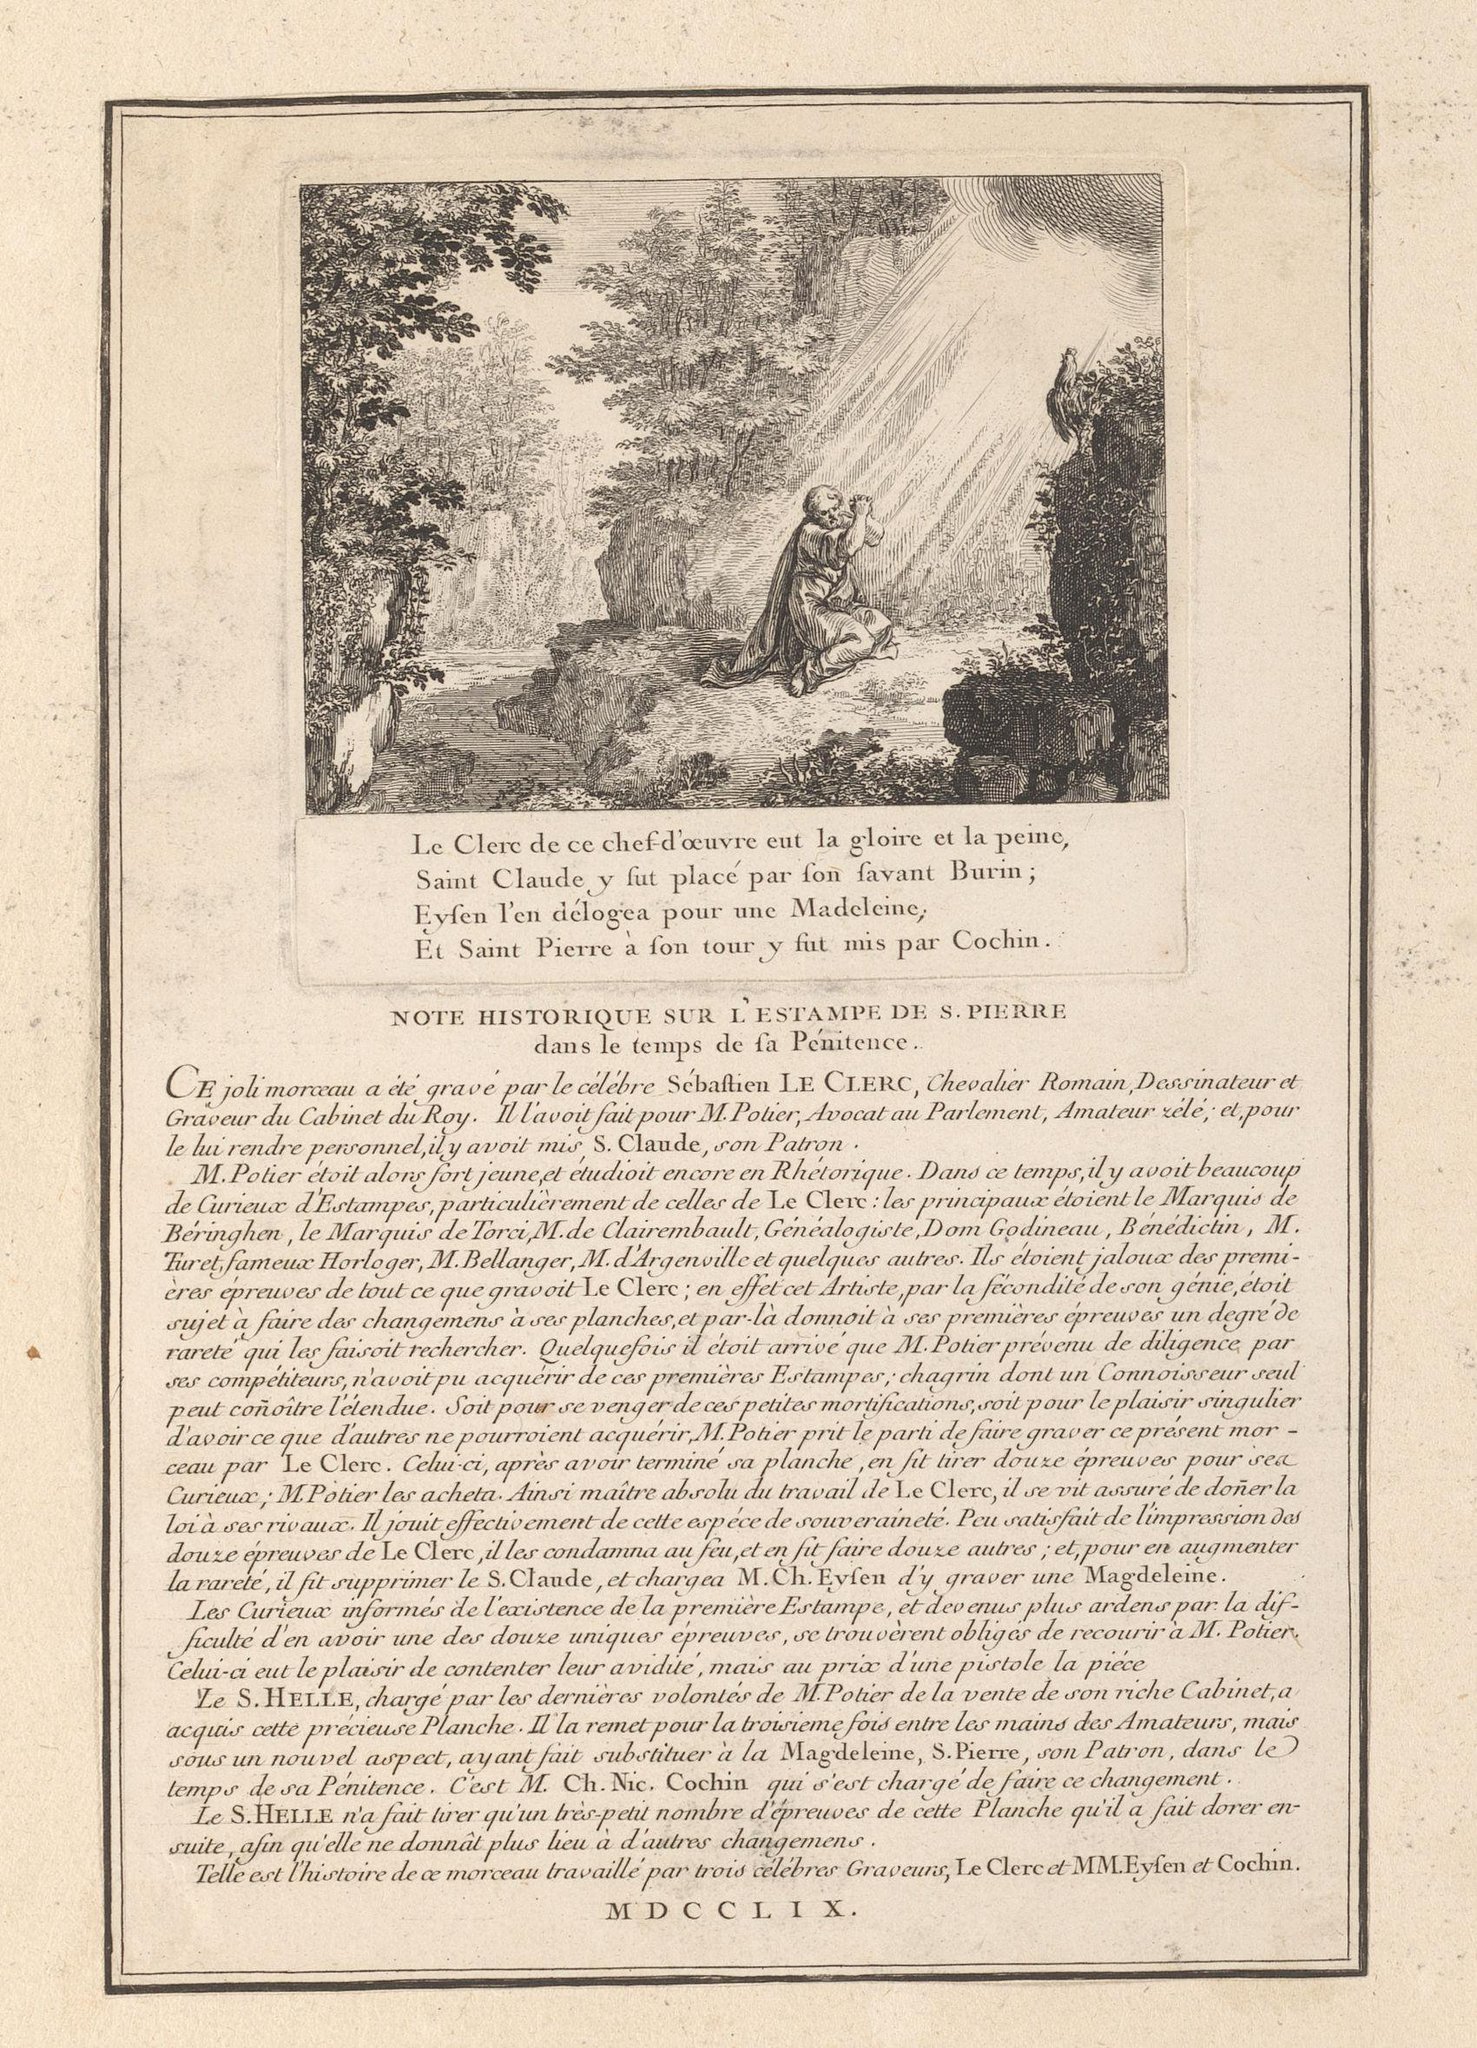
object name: print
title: Knielende Petrus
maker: sébastien leclerc (i)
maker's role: print maker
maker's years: 1637-1714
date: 1647-1714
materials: paper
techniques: etching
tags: the apostle peter, first bishop of rome; possible attributes: book, cock, (upturned) cross, (triple) crozier, fish, key, scroll, ship, tiara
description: Met aanpassingen door Charles Nicolas Cochin.